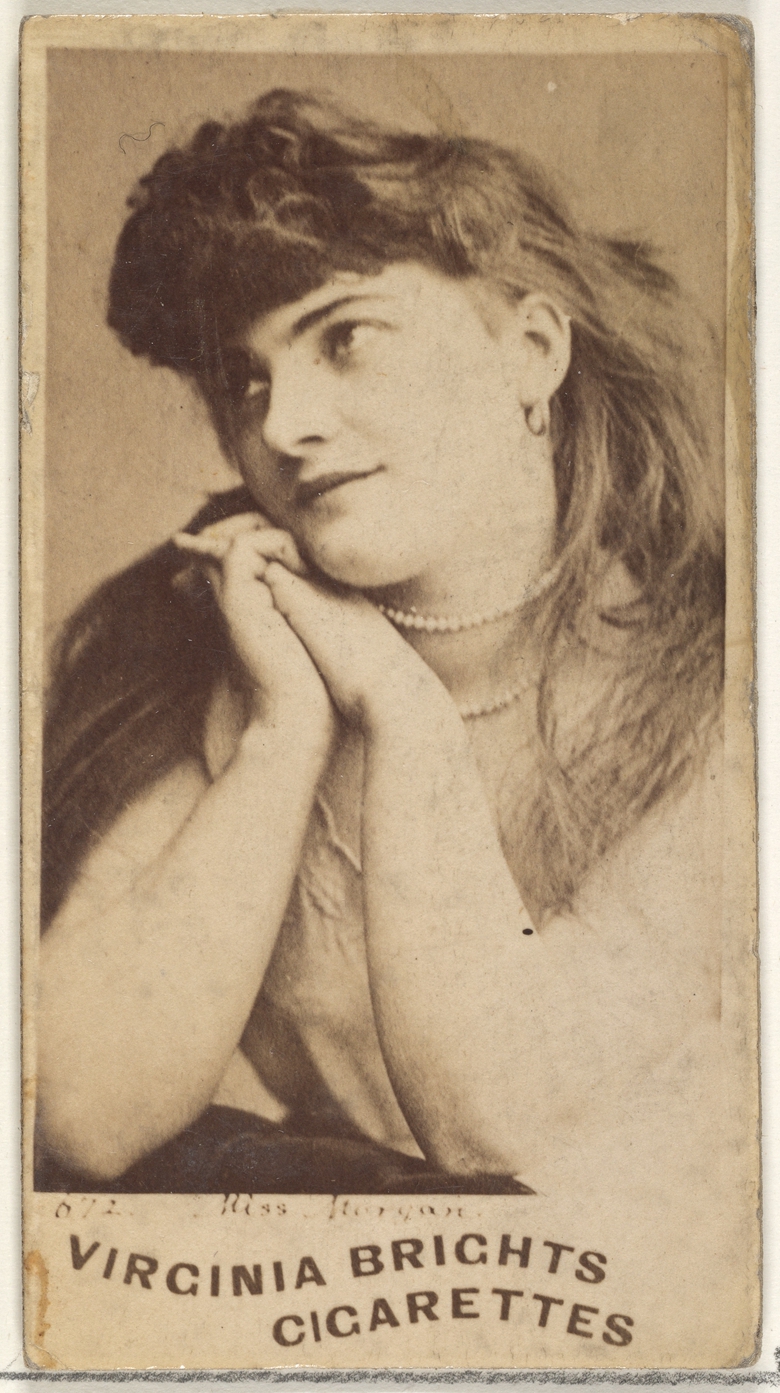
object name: photograph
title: Card 672, Miss Morgan, from the Actors and Actresses series (N45, Type 1) for Virginia Brights Cigarettes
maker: allen & ginter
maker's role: publisher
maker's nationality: american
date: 1888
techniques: albumen silver print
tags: portraits,women,actresses